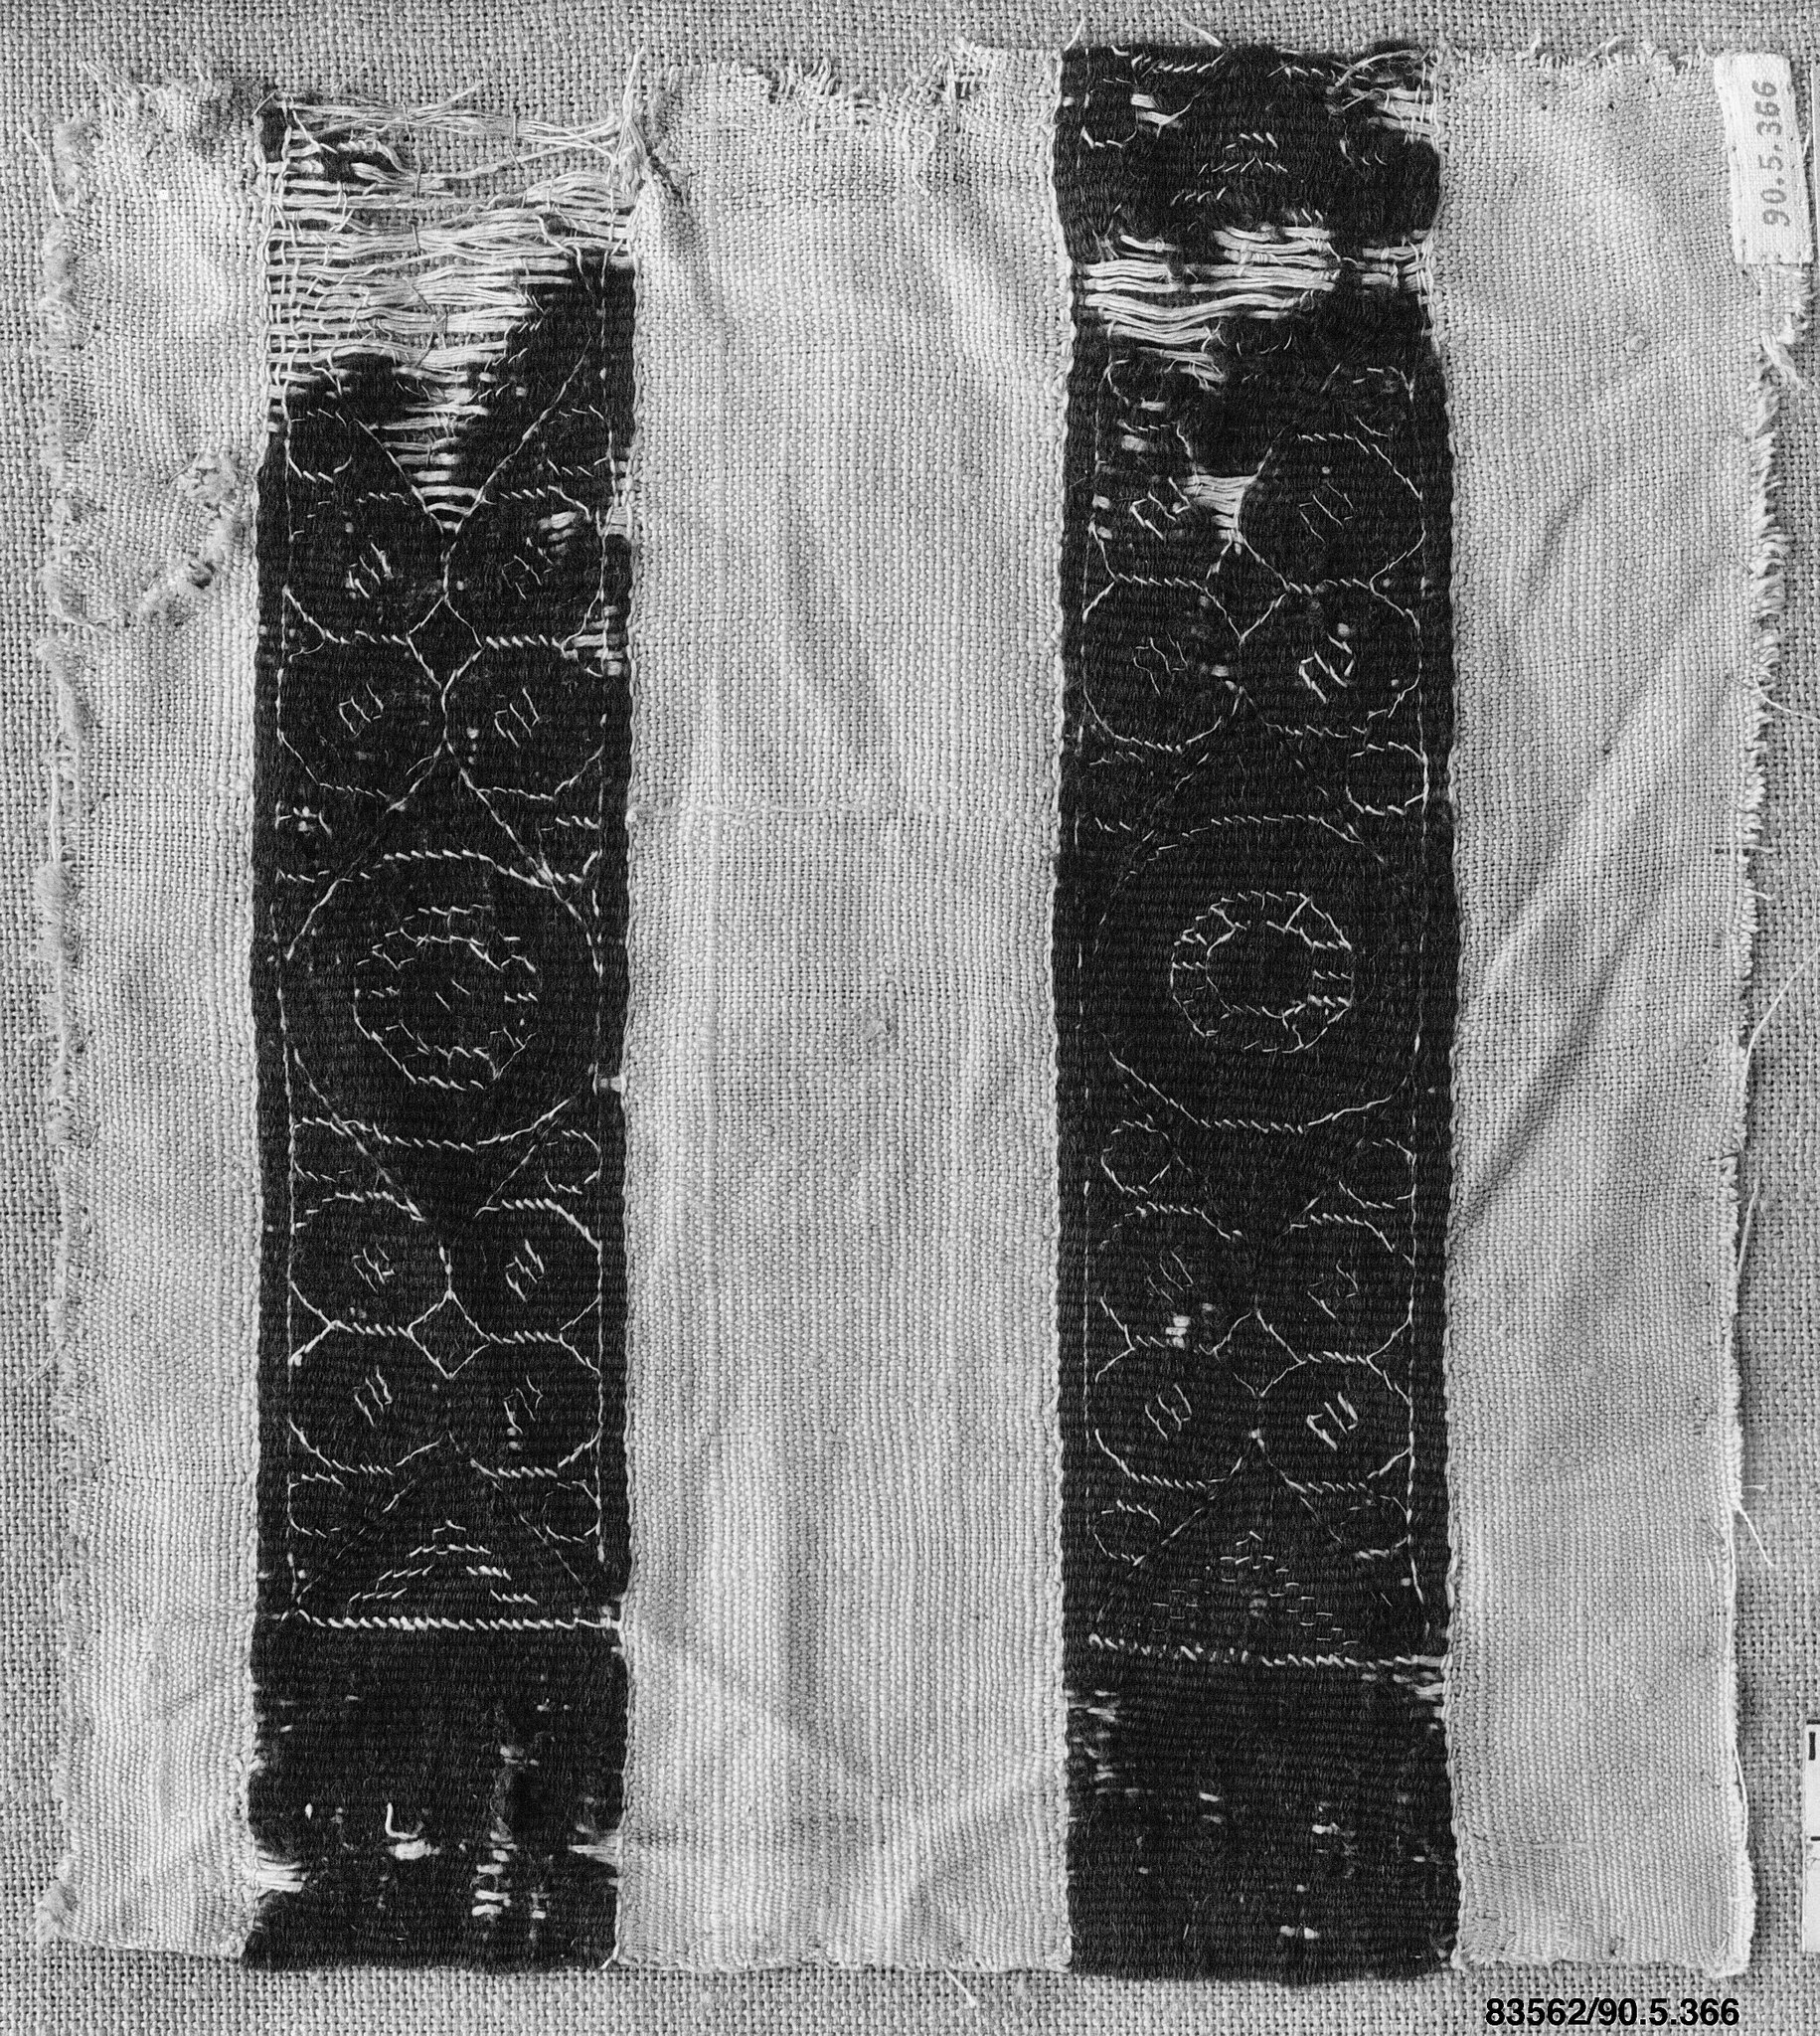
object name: textile fragment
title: Fragment of a Tunic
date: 201-400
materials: linen, wool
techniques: weave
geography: egypt